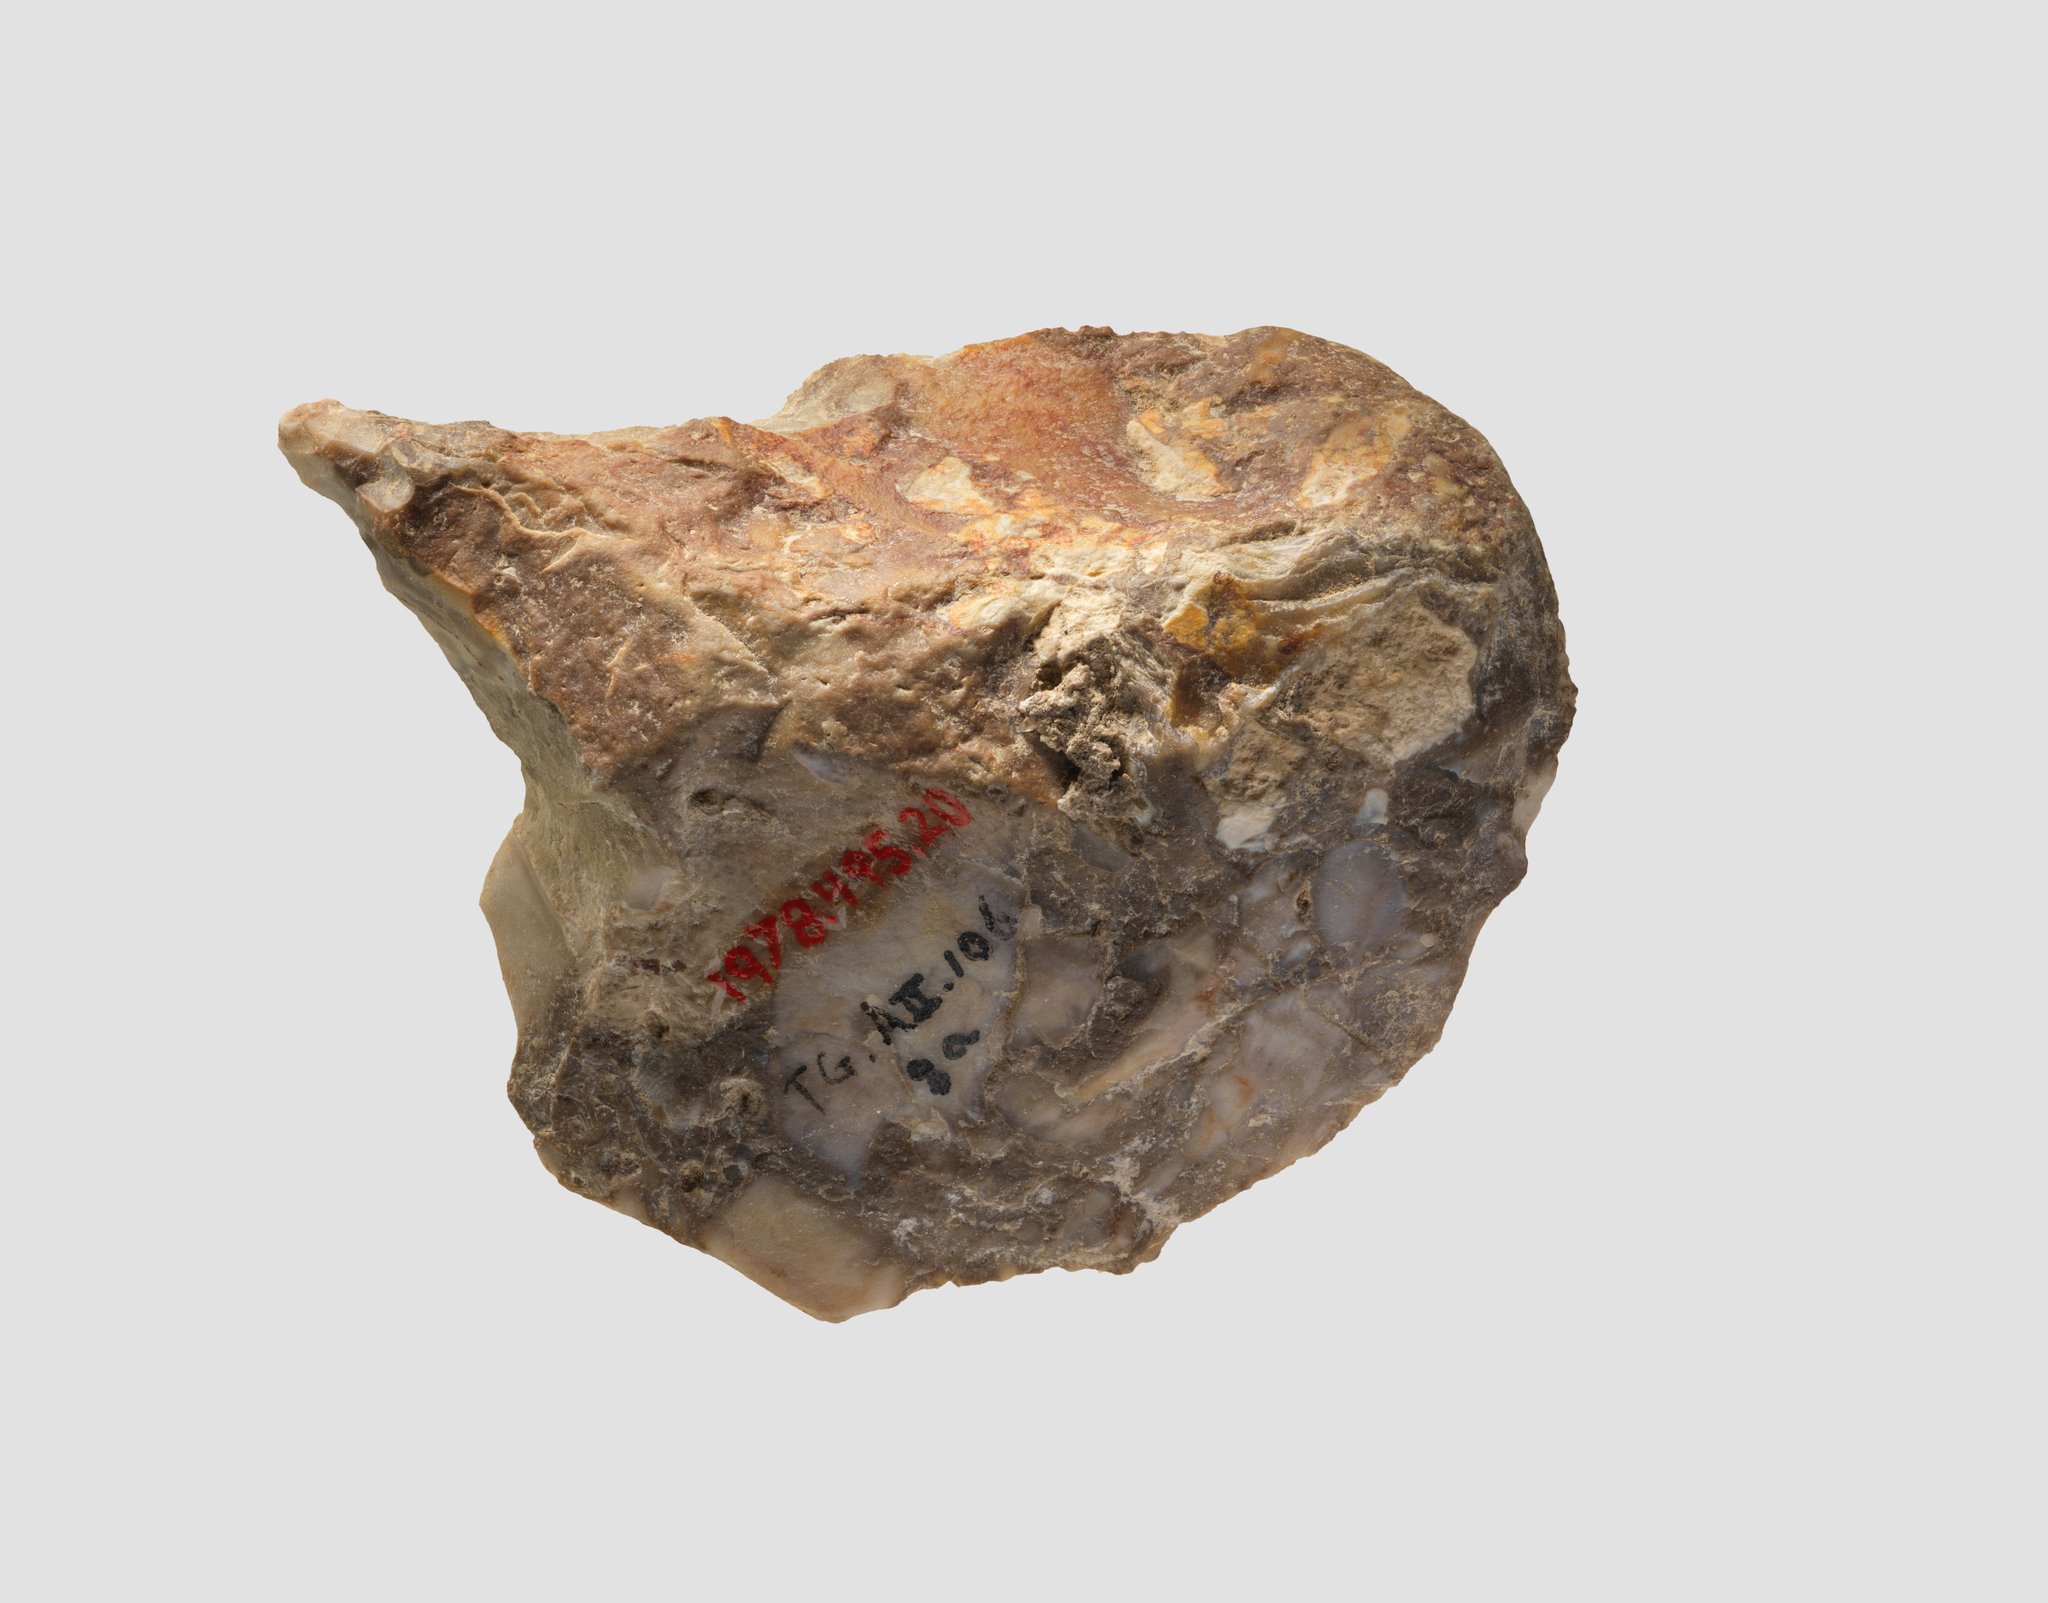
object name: awl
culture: ghassulian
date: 4600-3600 BCE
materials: stone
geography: levant